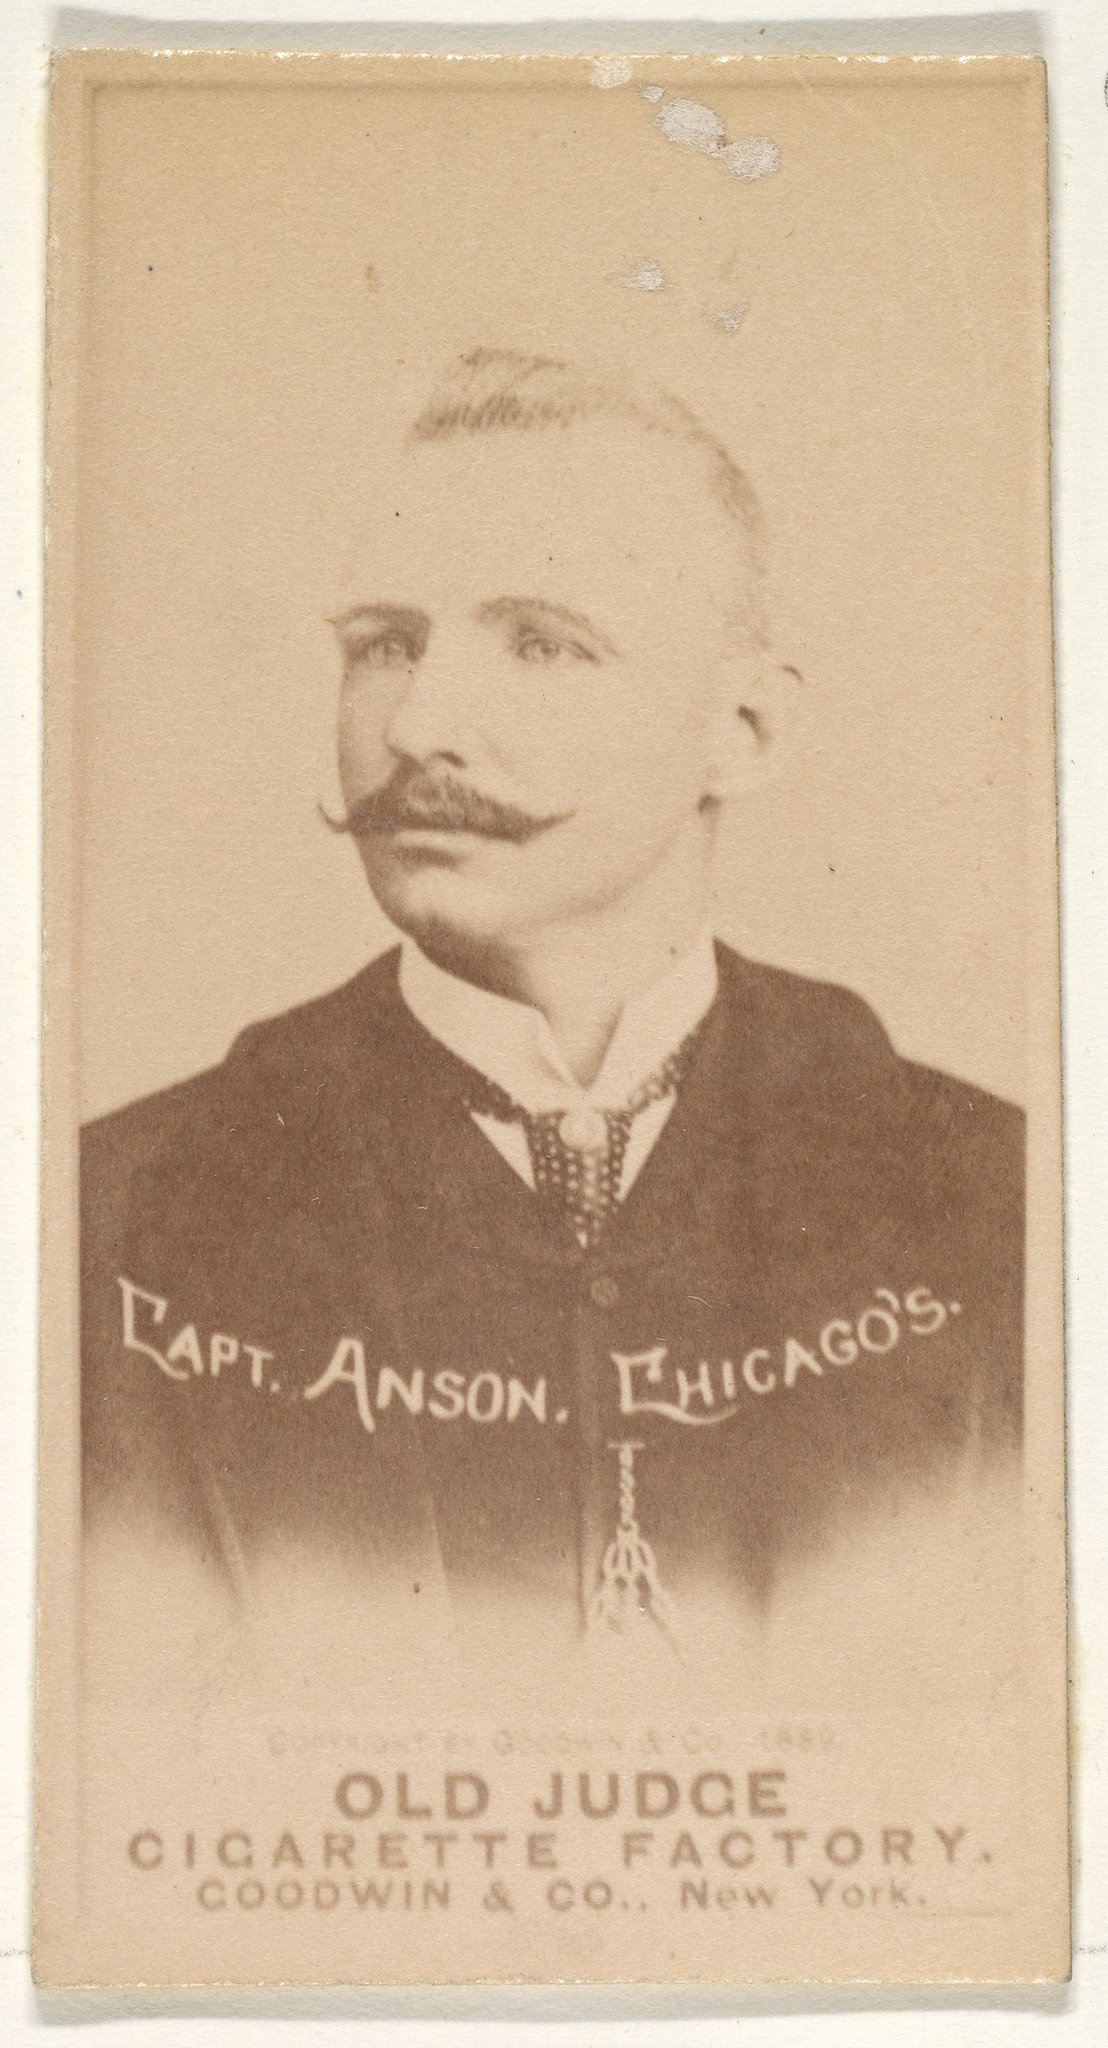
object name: baseball card, photograph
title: Anson, Captain, Chicago, from the Old Judge series (N172) for Old Judge Cigarettes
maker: goodwin & company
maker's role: publisher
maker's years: 1850-1950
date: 1887-1890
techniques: albumen silver print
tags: men,portraits,athletes